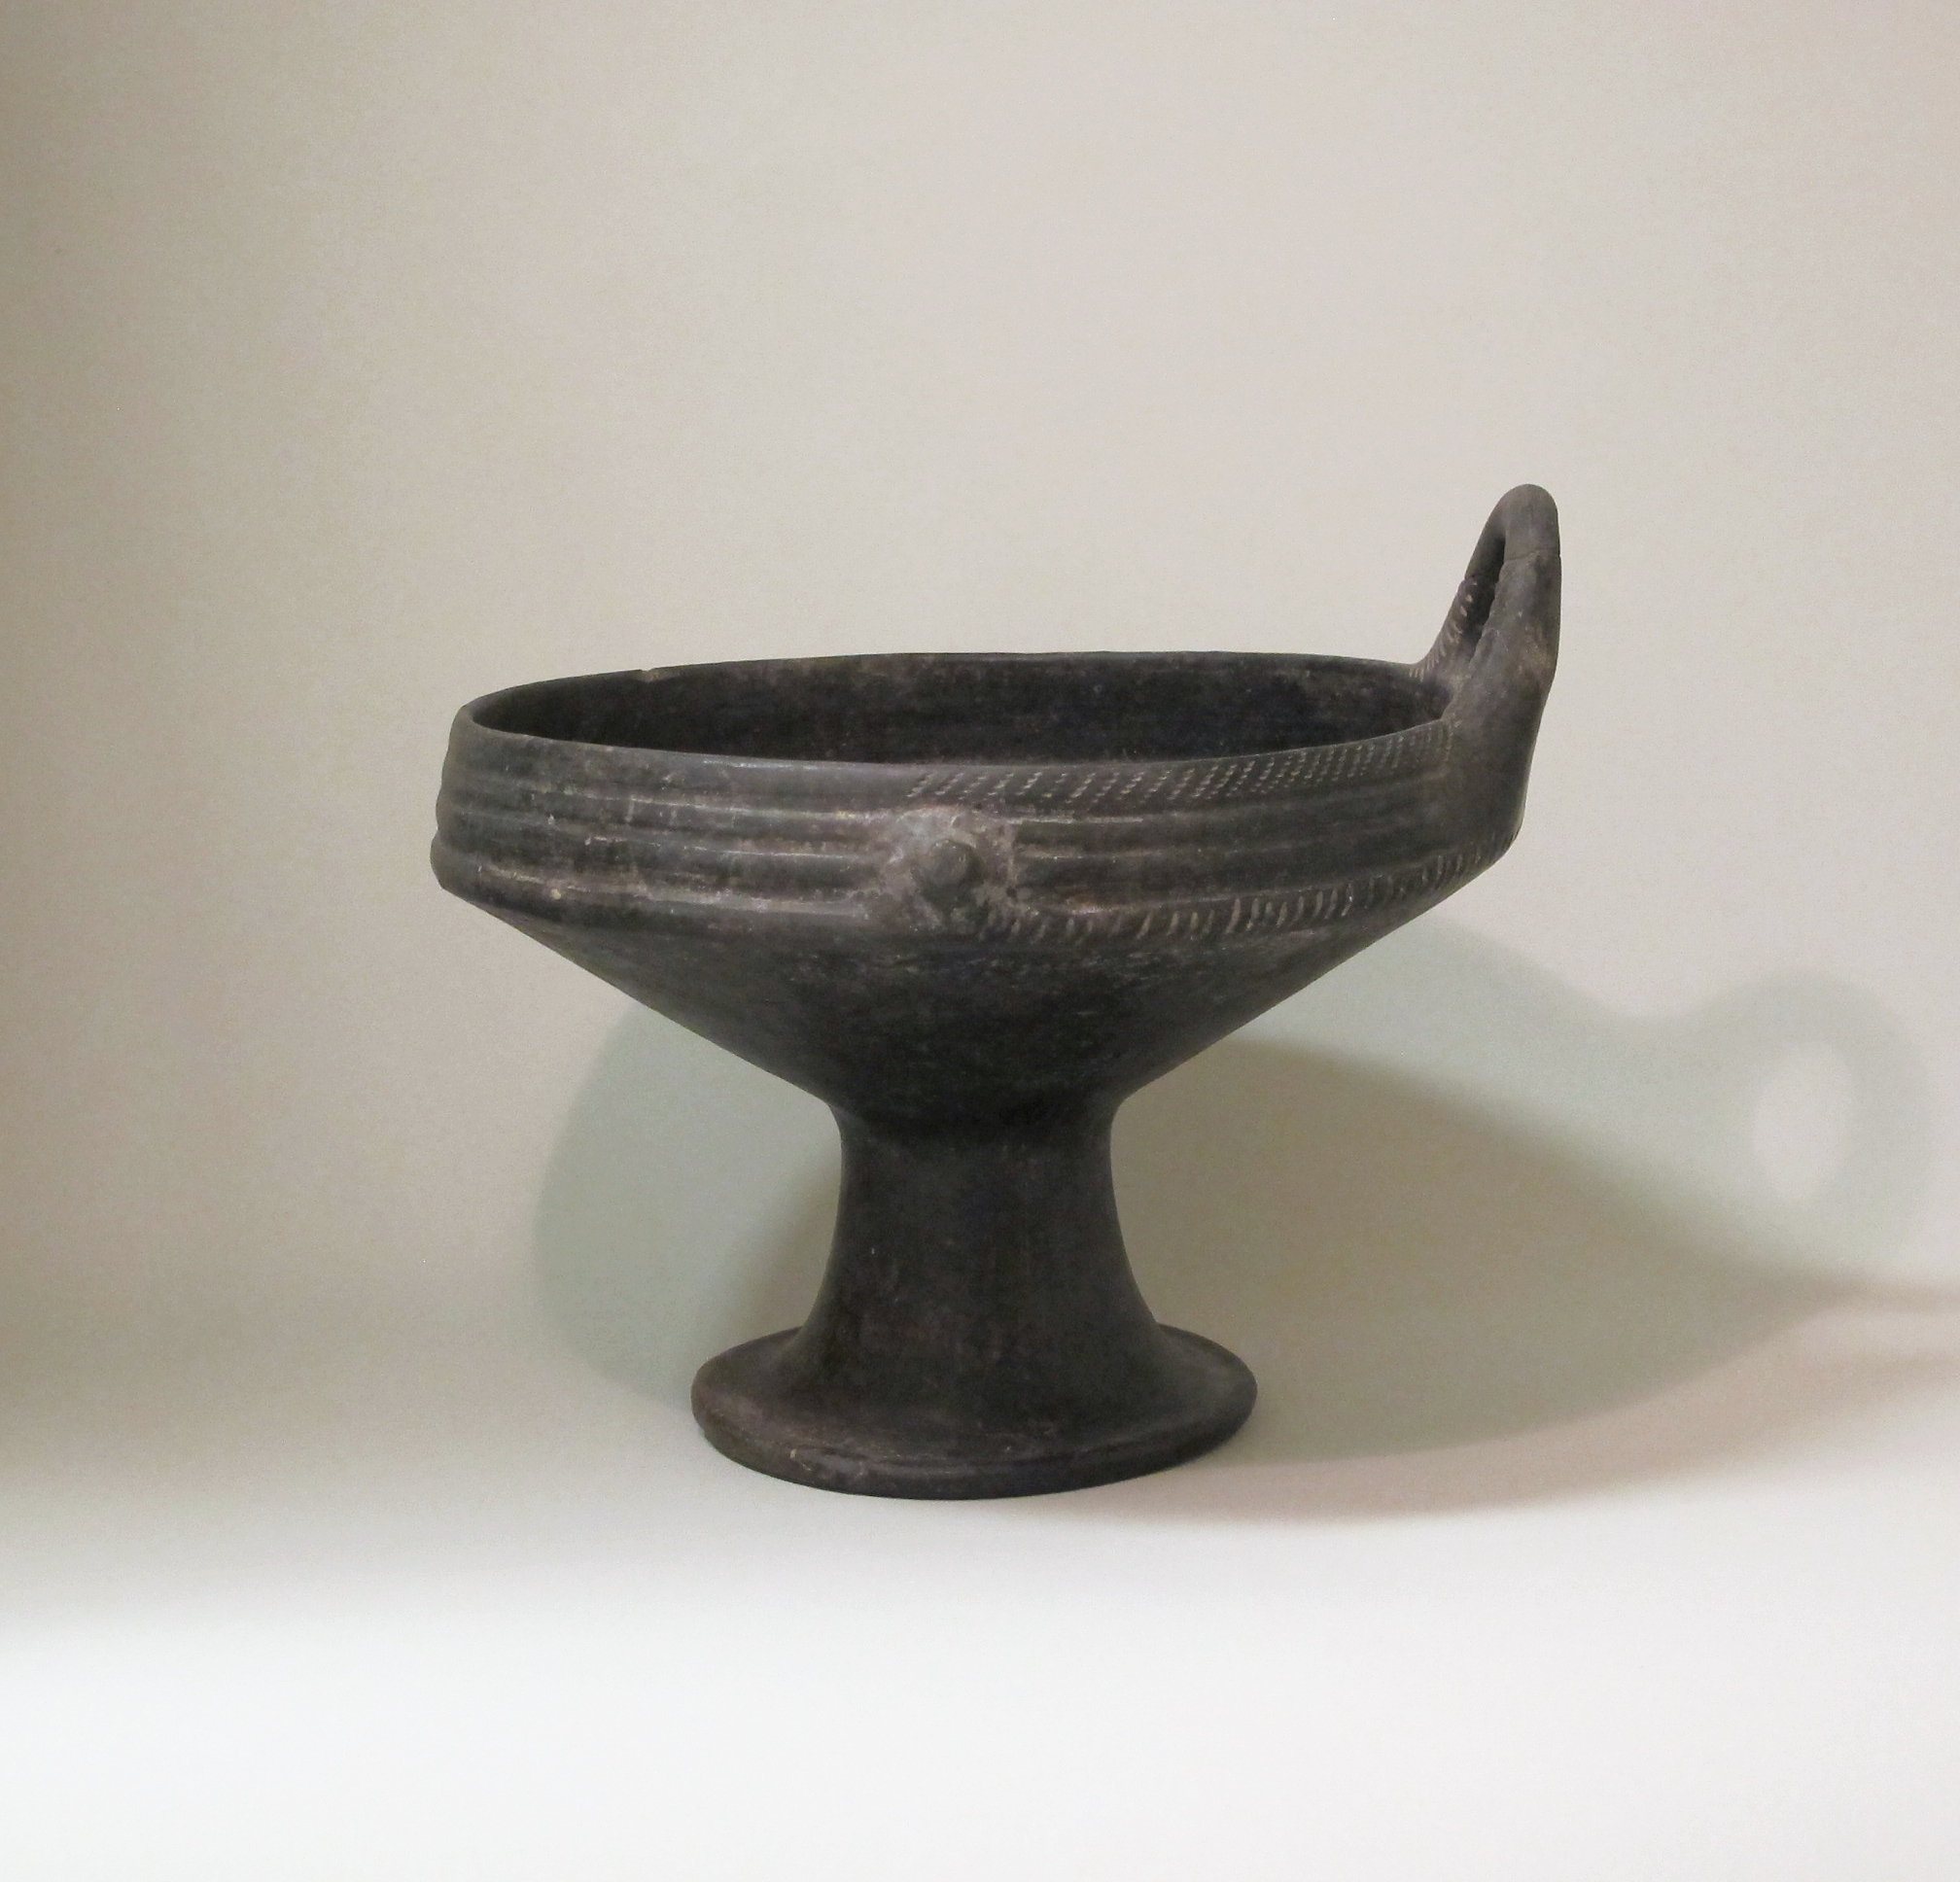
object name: vase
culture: etruscan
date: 700-651 BCE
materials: terracotta